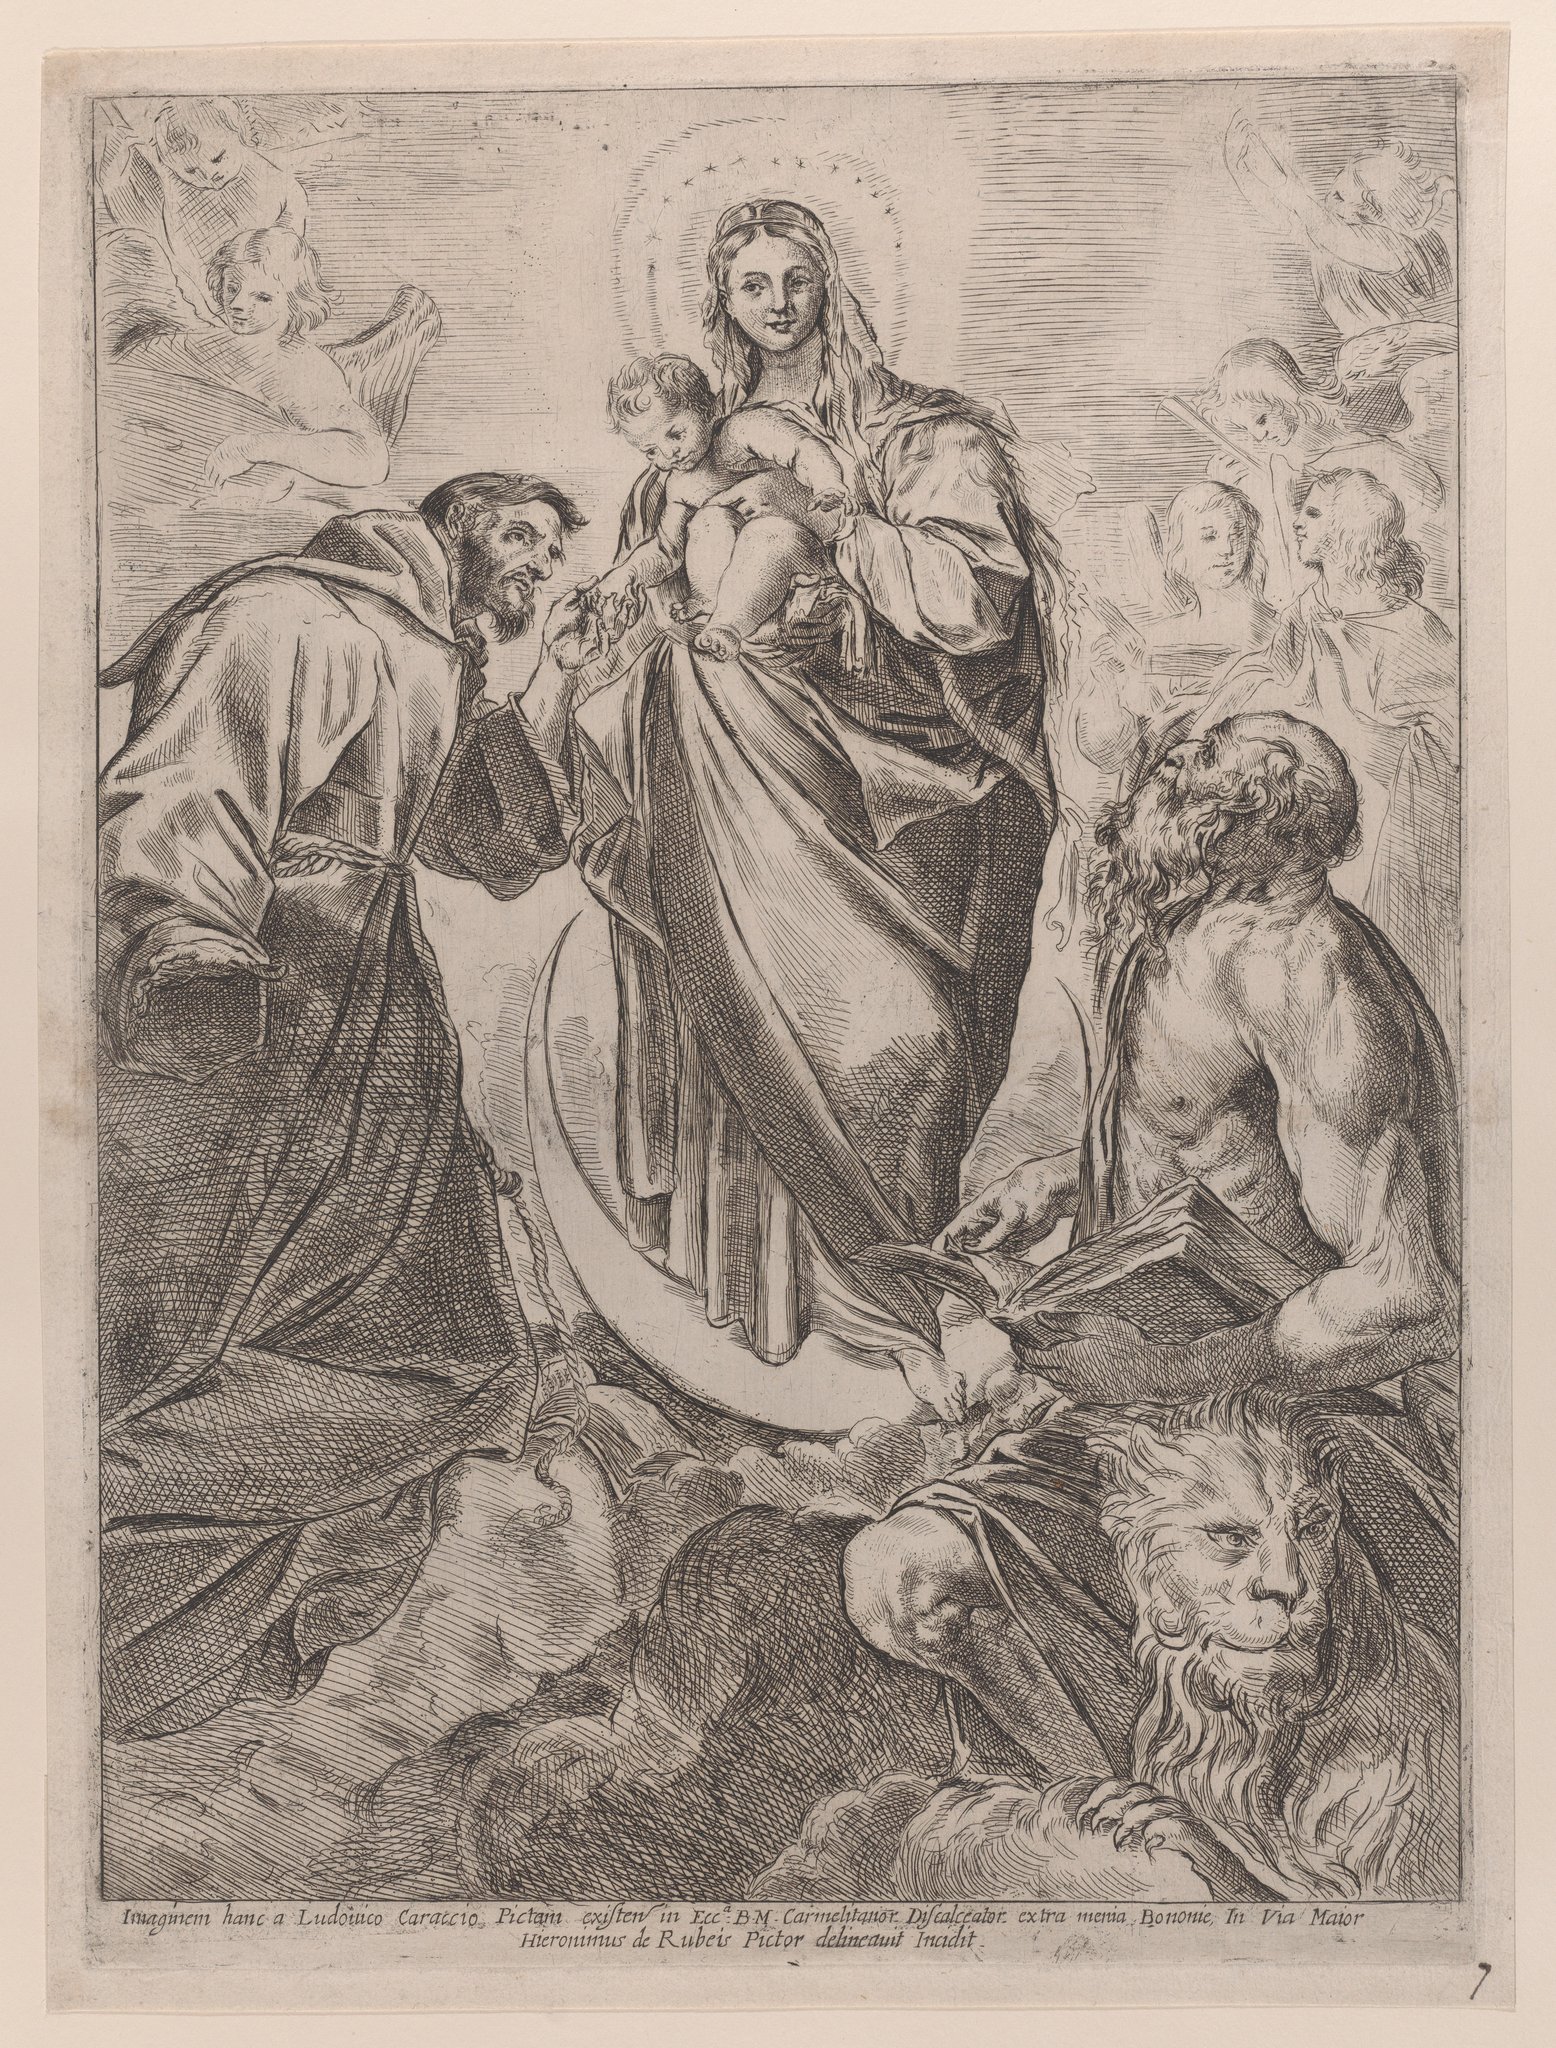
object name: print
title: The Virgin with Saints Jerome and Francis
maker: girolamo rossi, the elder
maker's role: artist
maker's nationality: italian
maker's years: 1630-1700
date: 1660-1680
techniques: etching